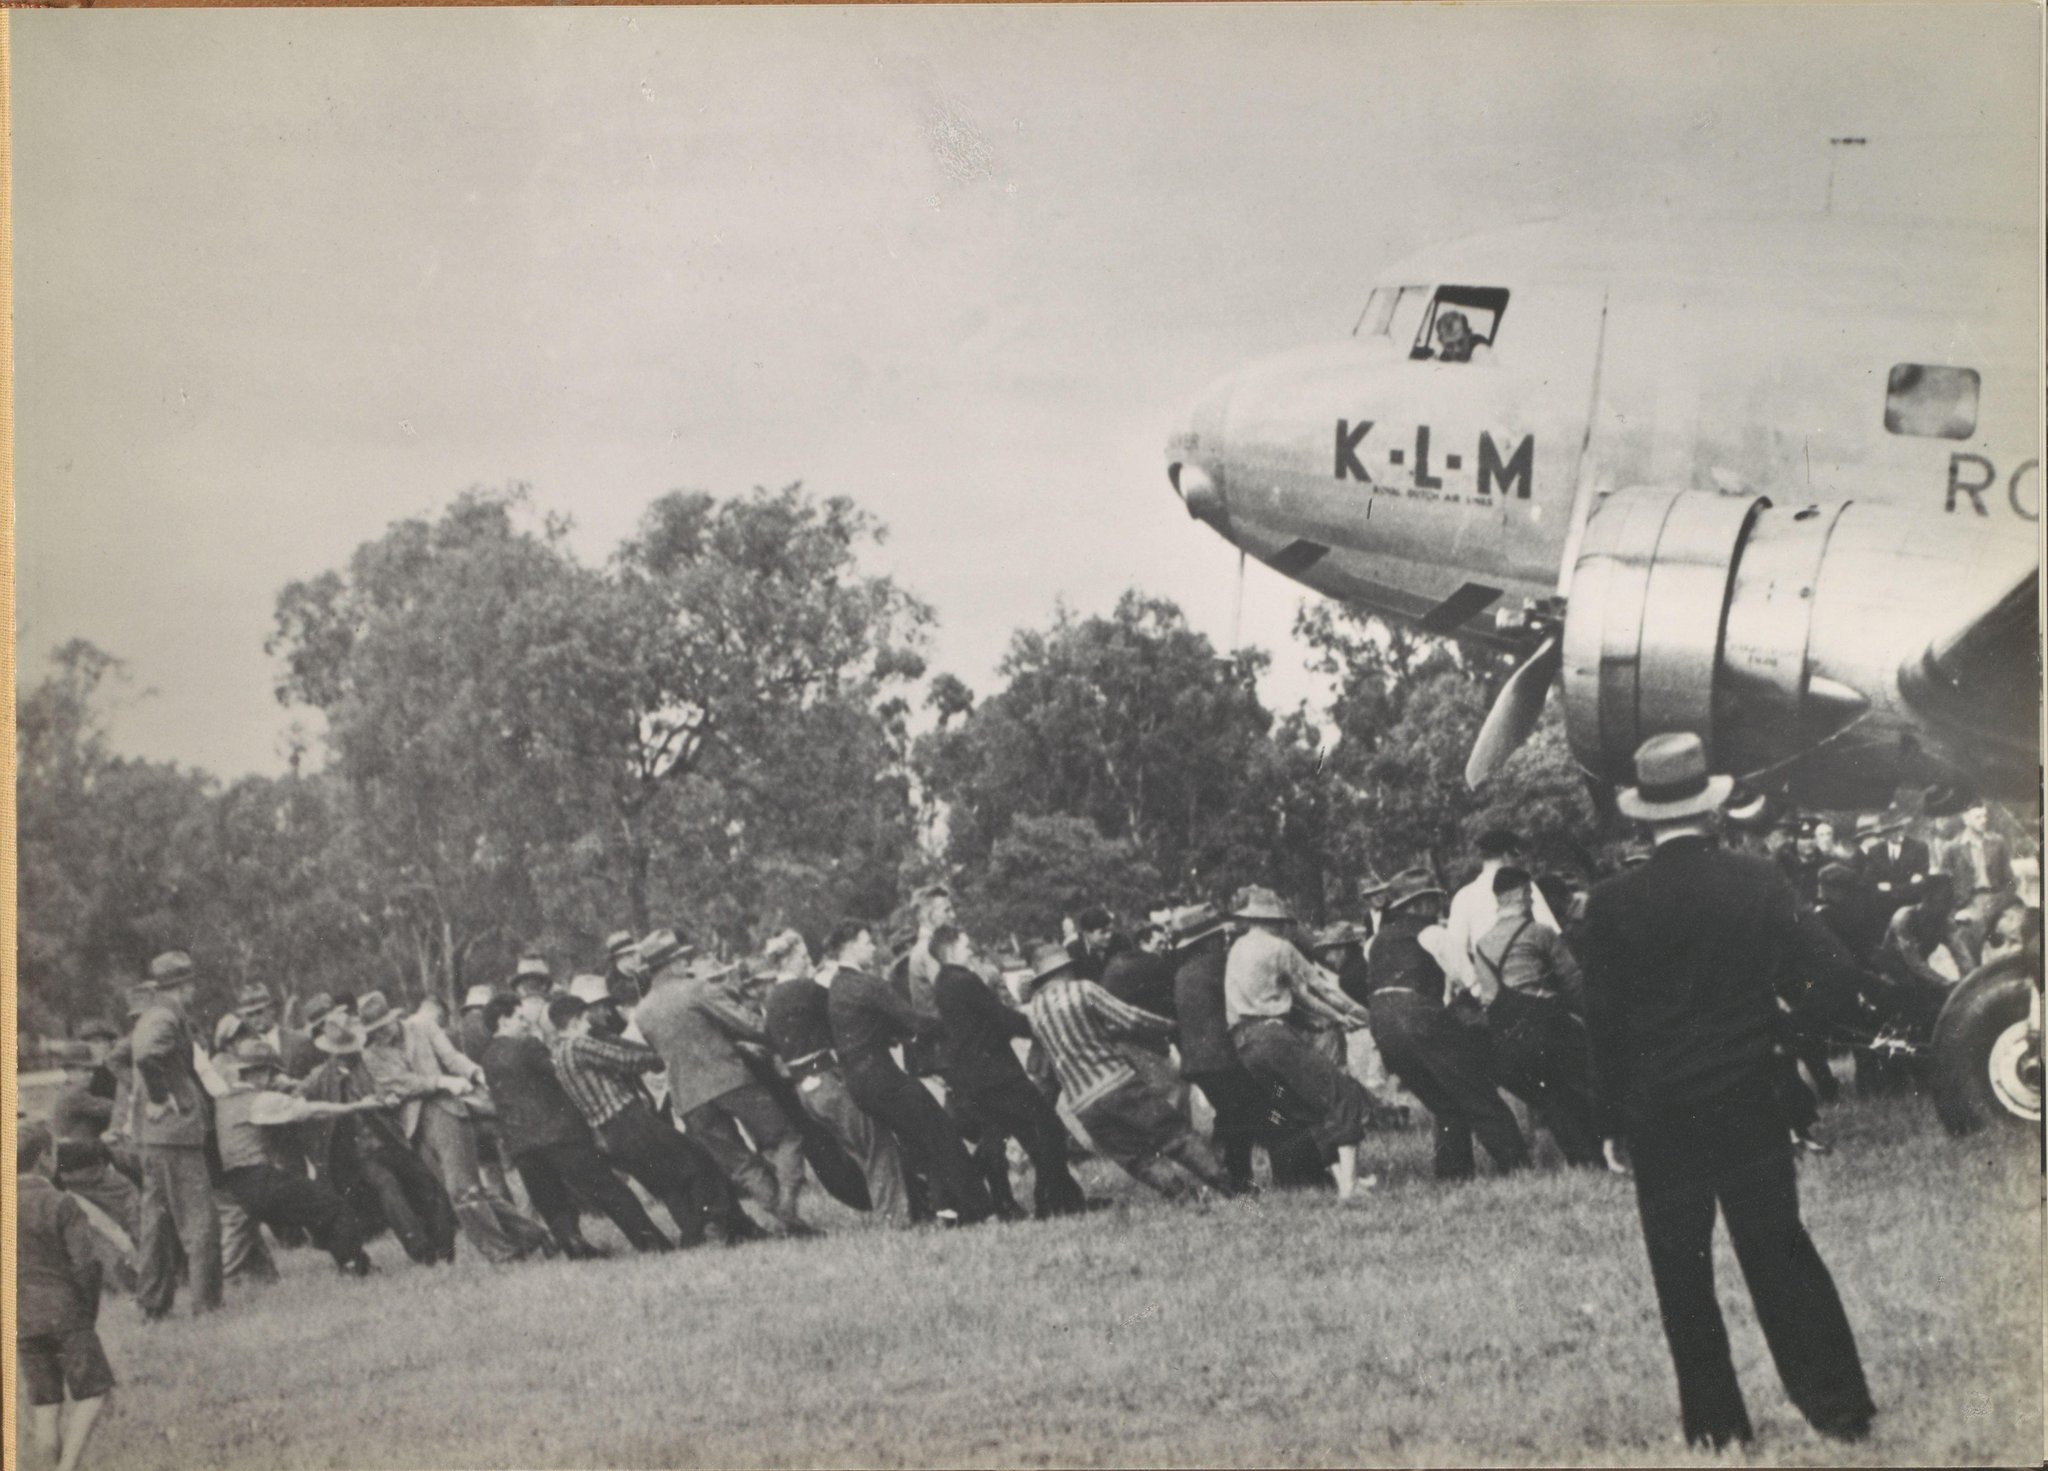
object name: photograph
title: Mannen trekken de 'Uiver' uit de modder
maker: Anonymous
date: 1934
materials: cardboard, paper, photographic support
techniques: gelatin silver print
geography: albury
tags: aircraft, aeroplane, airborne traffic, aviation, travelling; tourism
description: Albumblad met een foto van een groep mannen die het KLM-toestel de 'Uiver' met behulp van een touw uit de modder van de paardenrenbaan van Albury (Australië) trekken. Het toestel, dat in 1934 meedeed aan de MacRobertson Londen - Melbourne luchtrace, moest vanwege slecht weer daar een noodlanding maken. Onderdeel van Herdenkingsalbum van de Indië-lijn van de KLM, deel I.